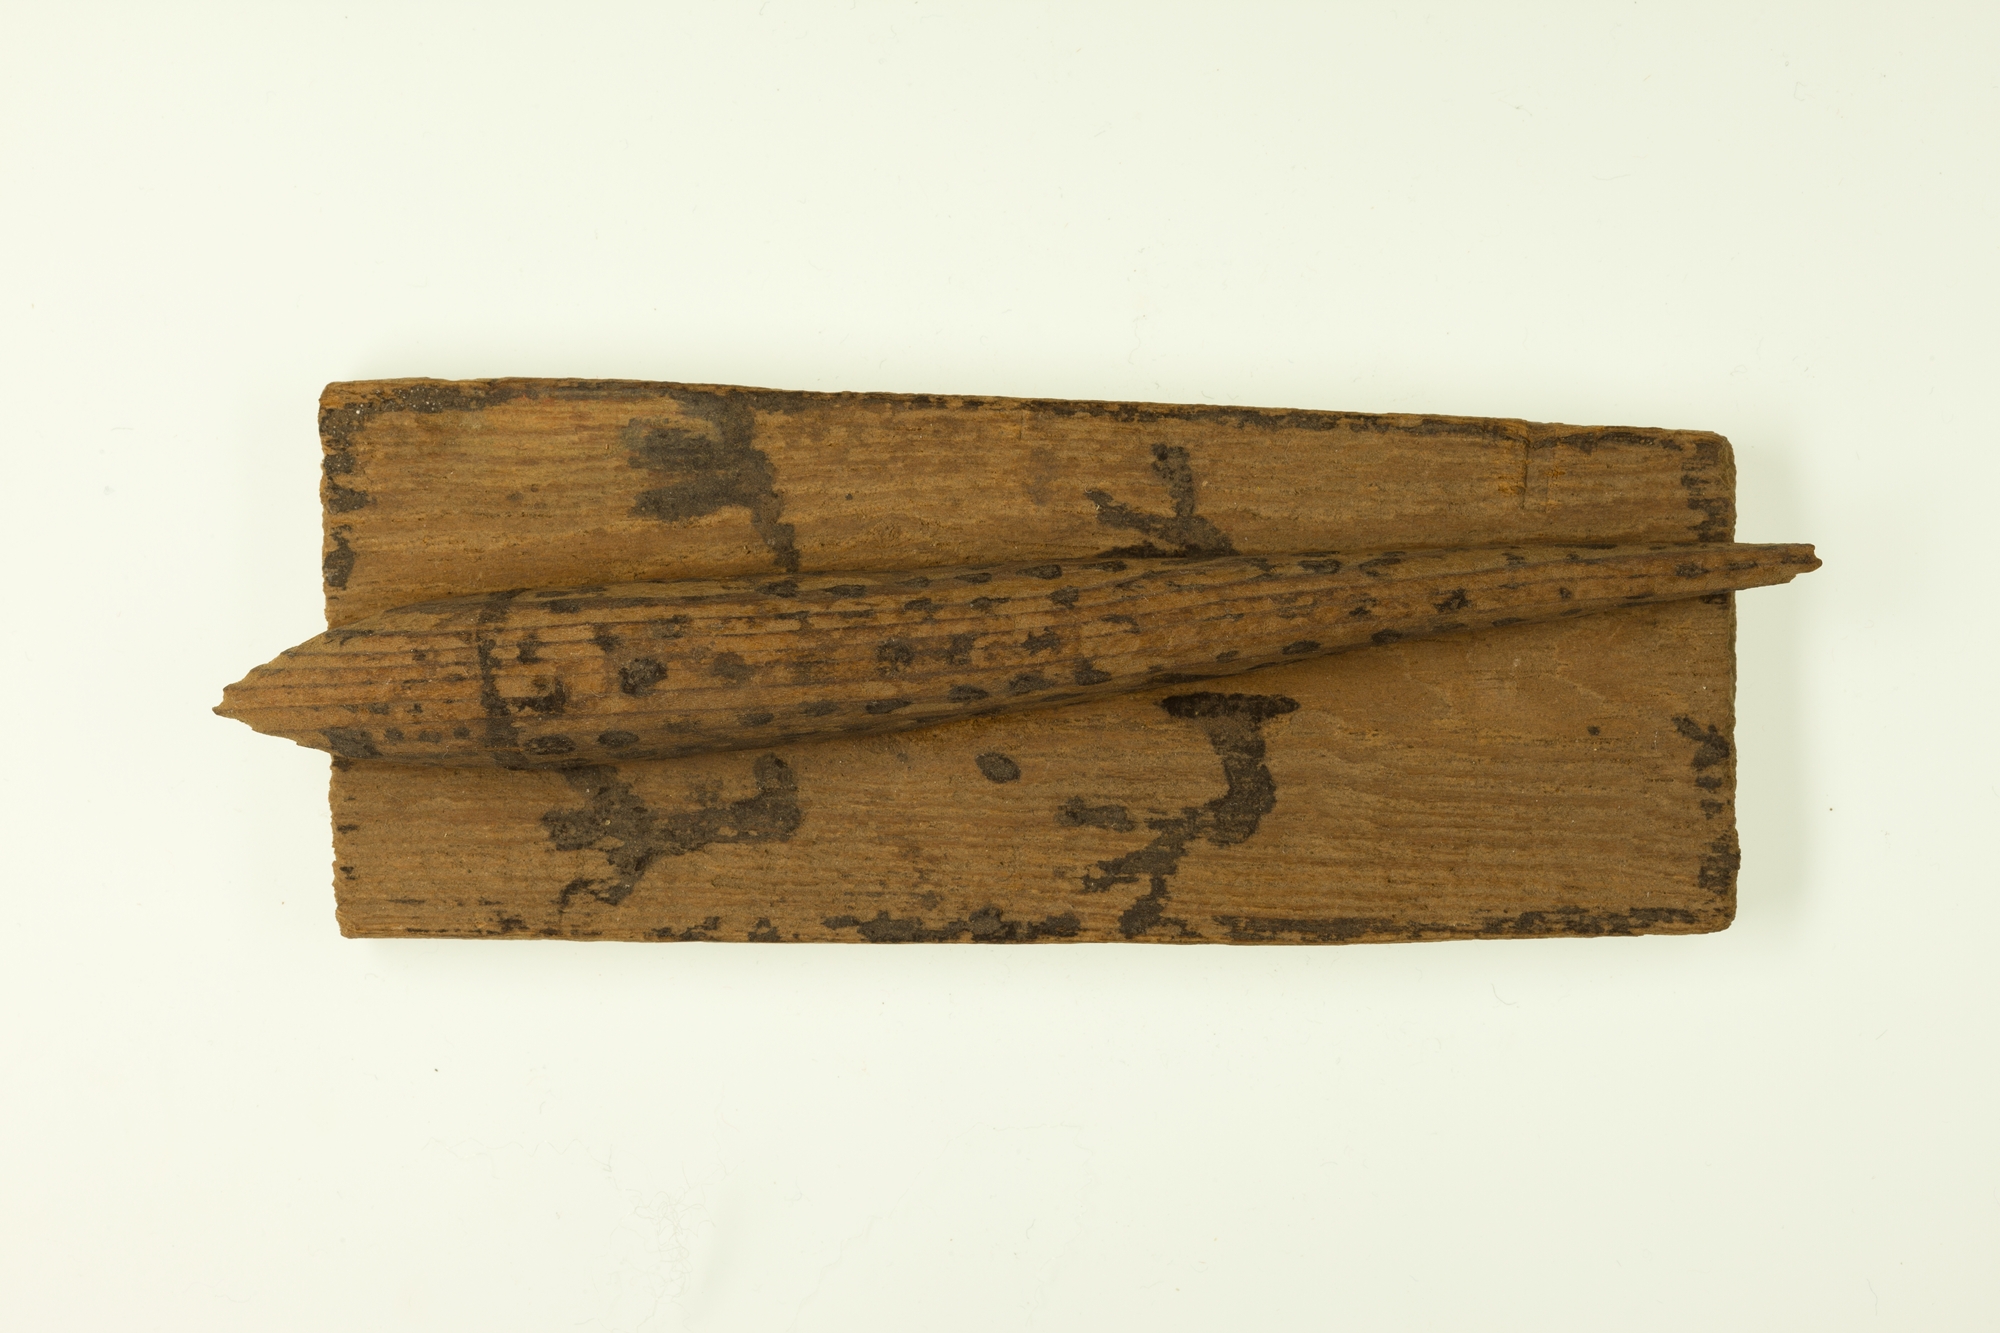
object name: figure, crocodile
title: Crocodile figure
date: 1295-1070 BCE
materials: wood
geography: egypt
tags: crocodiles